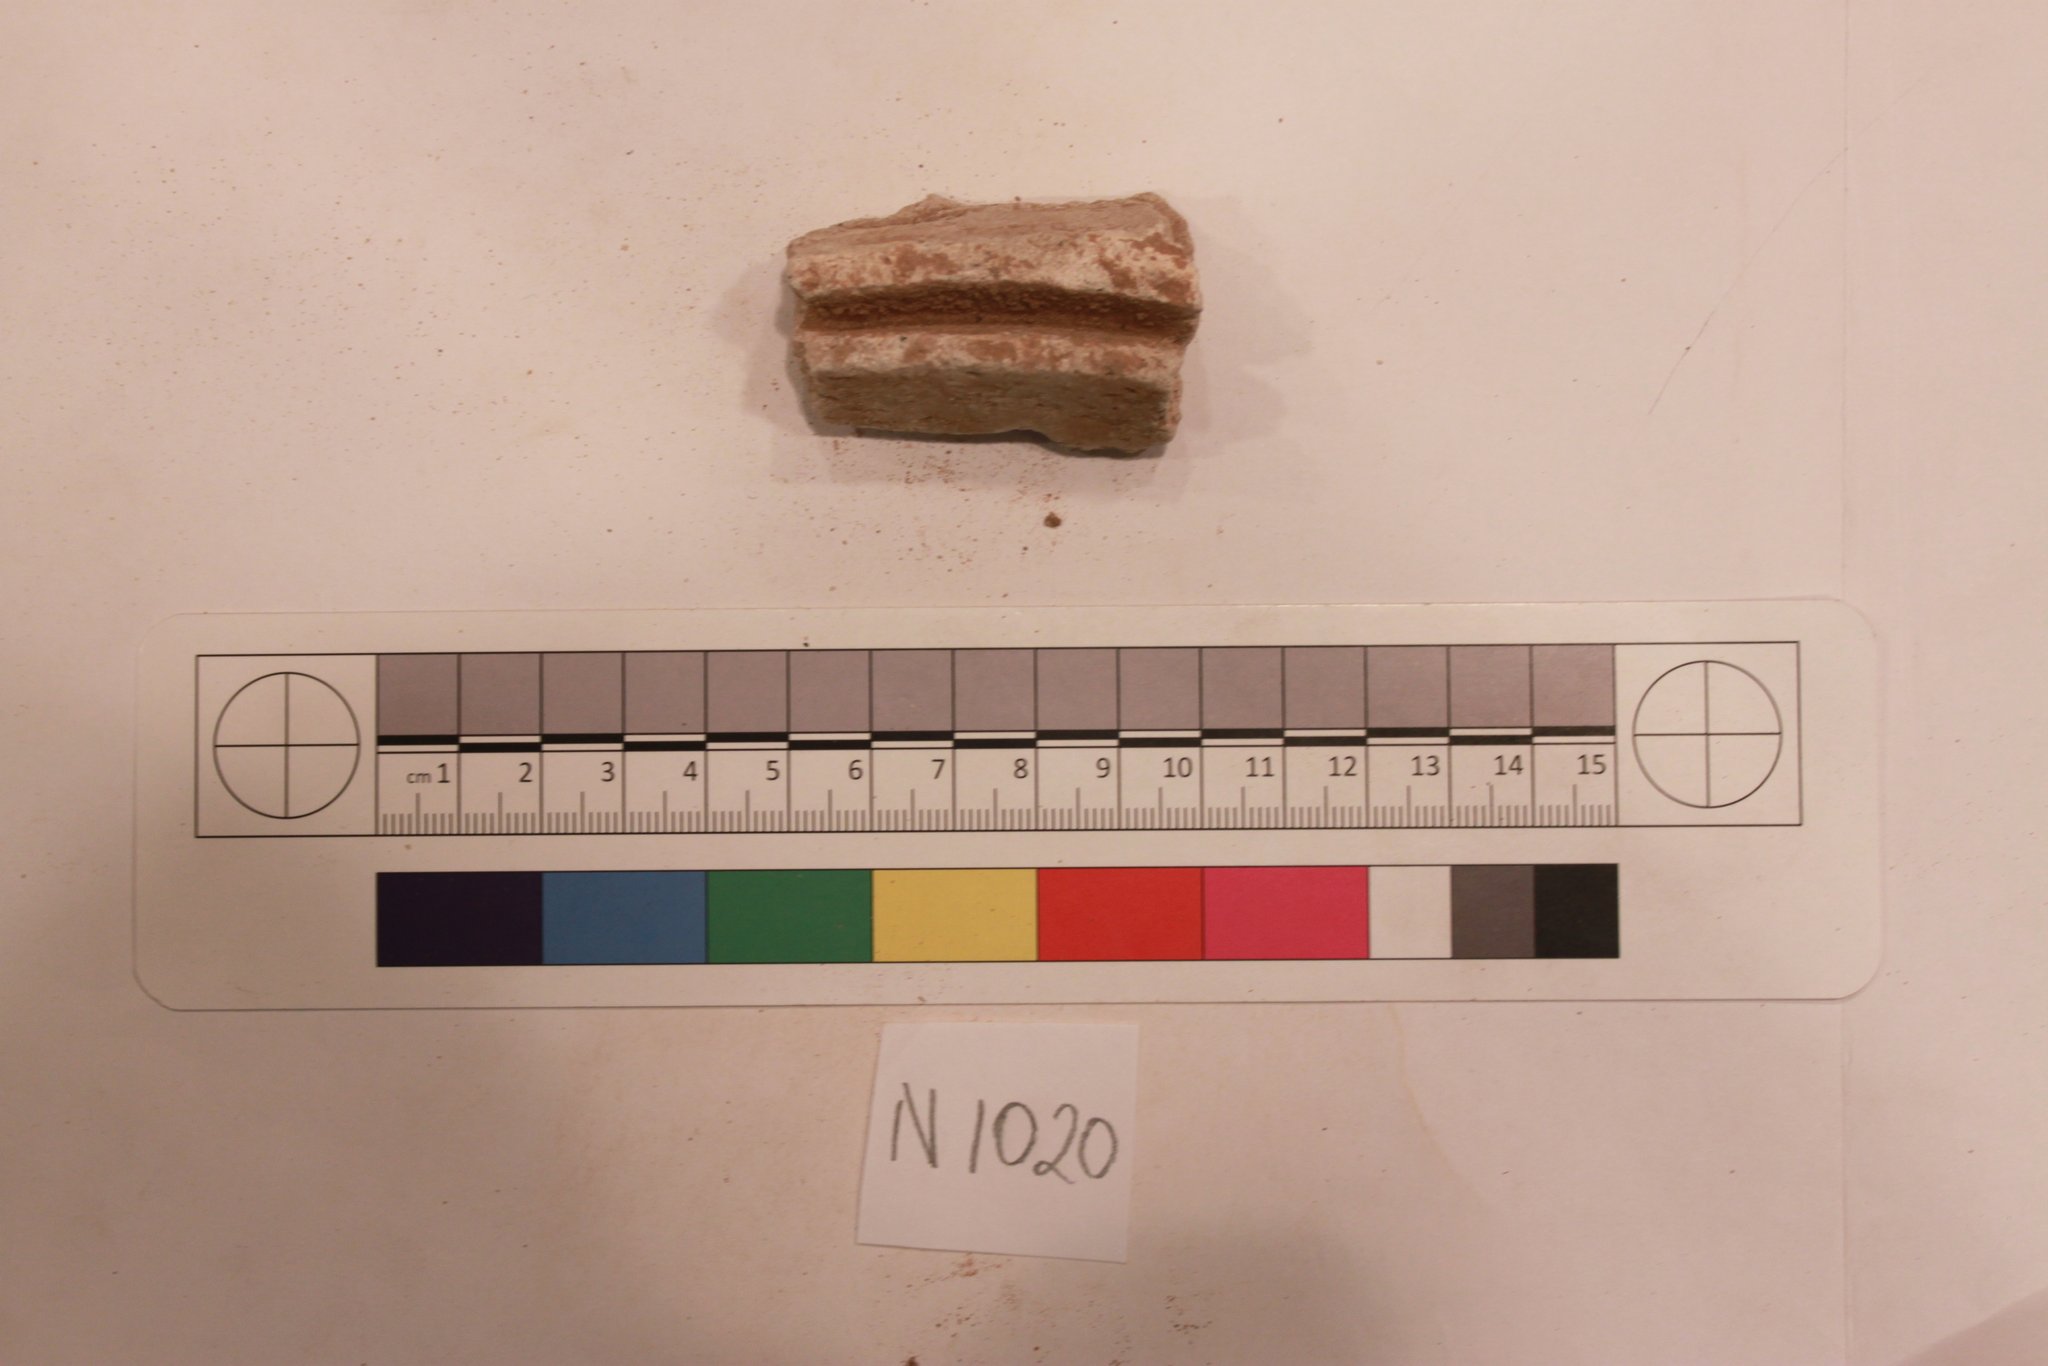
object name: fragment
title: Stucco Fragment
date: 701-1200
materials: plaster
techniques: carving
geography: iran